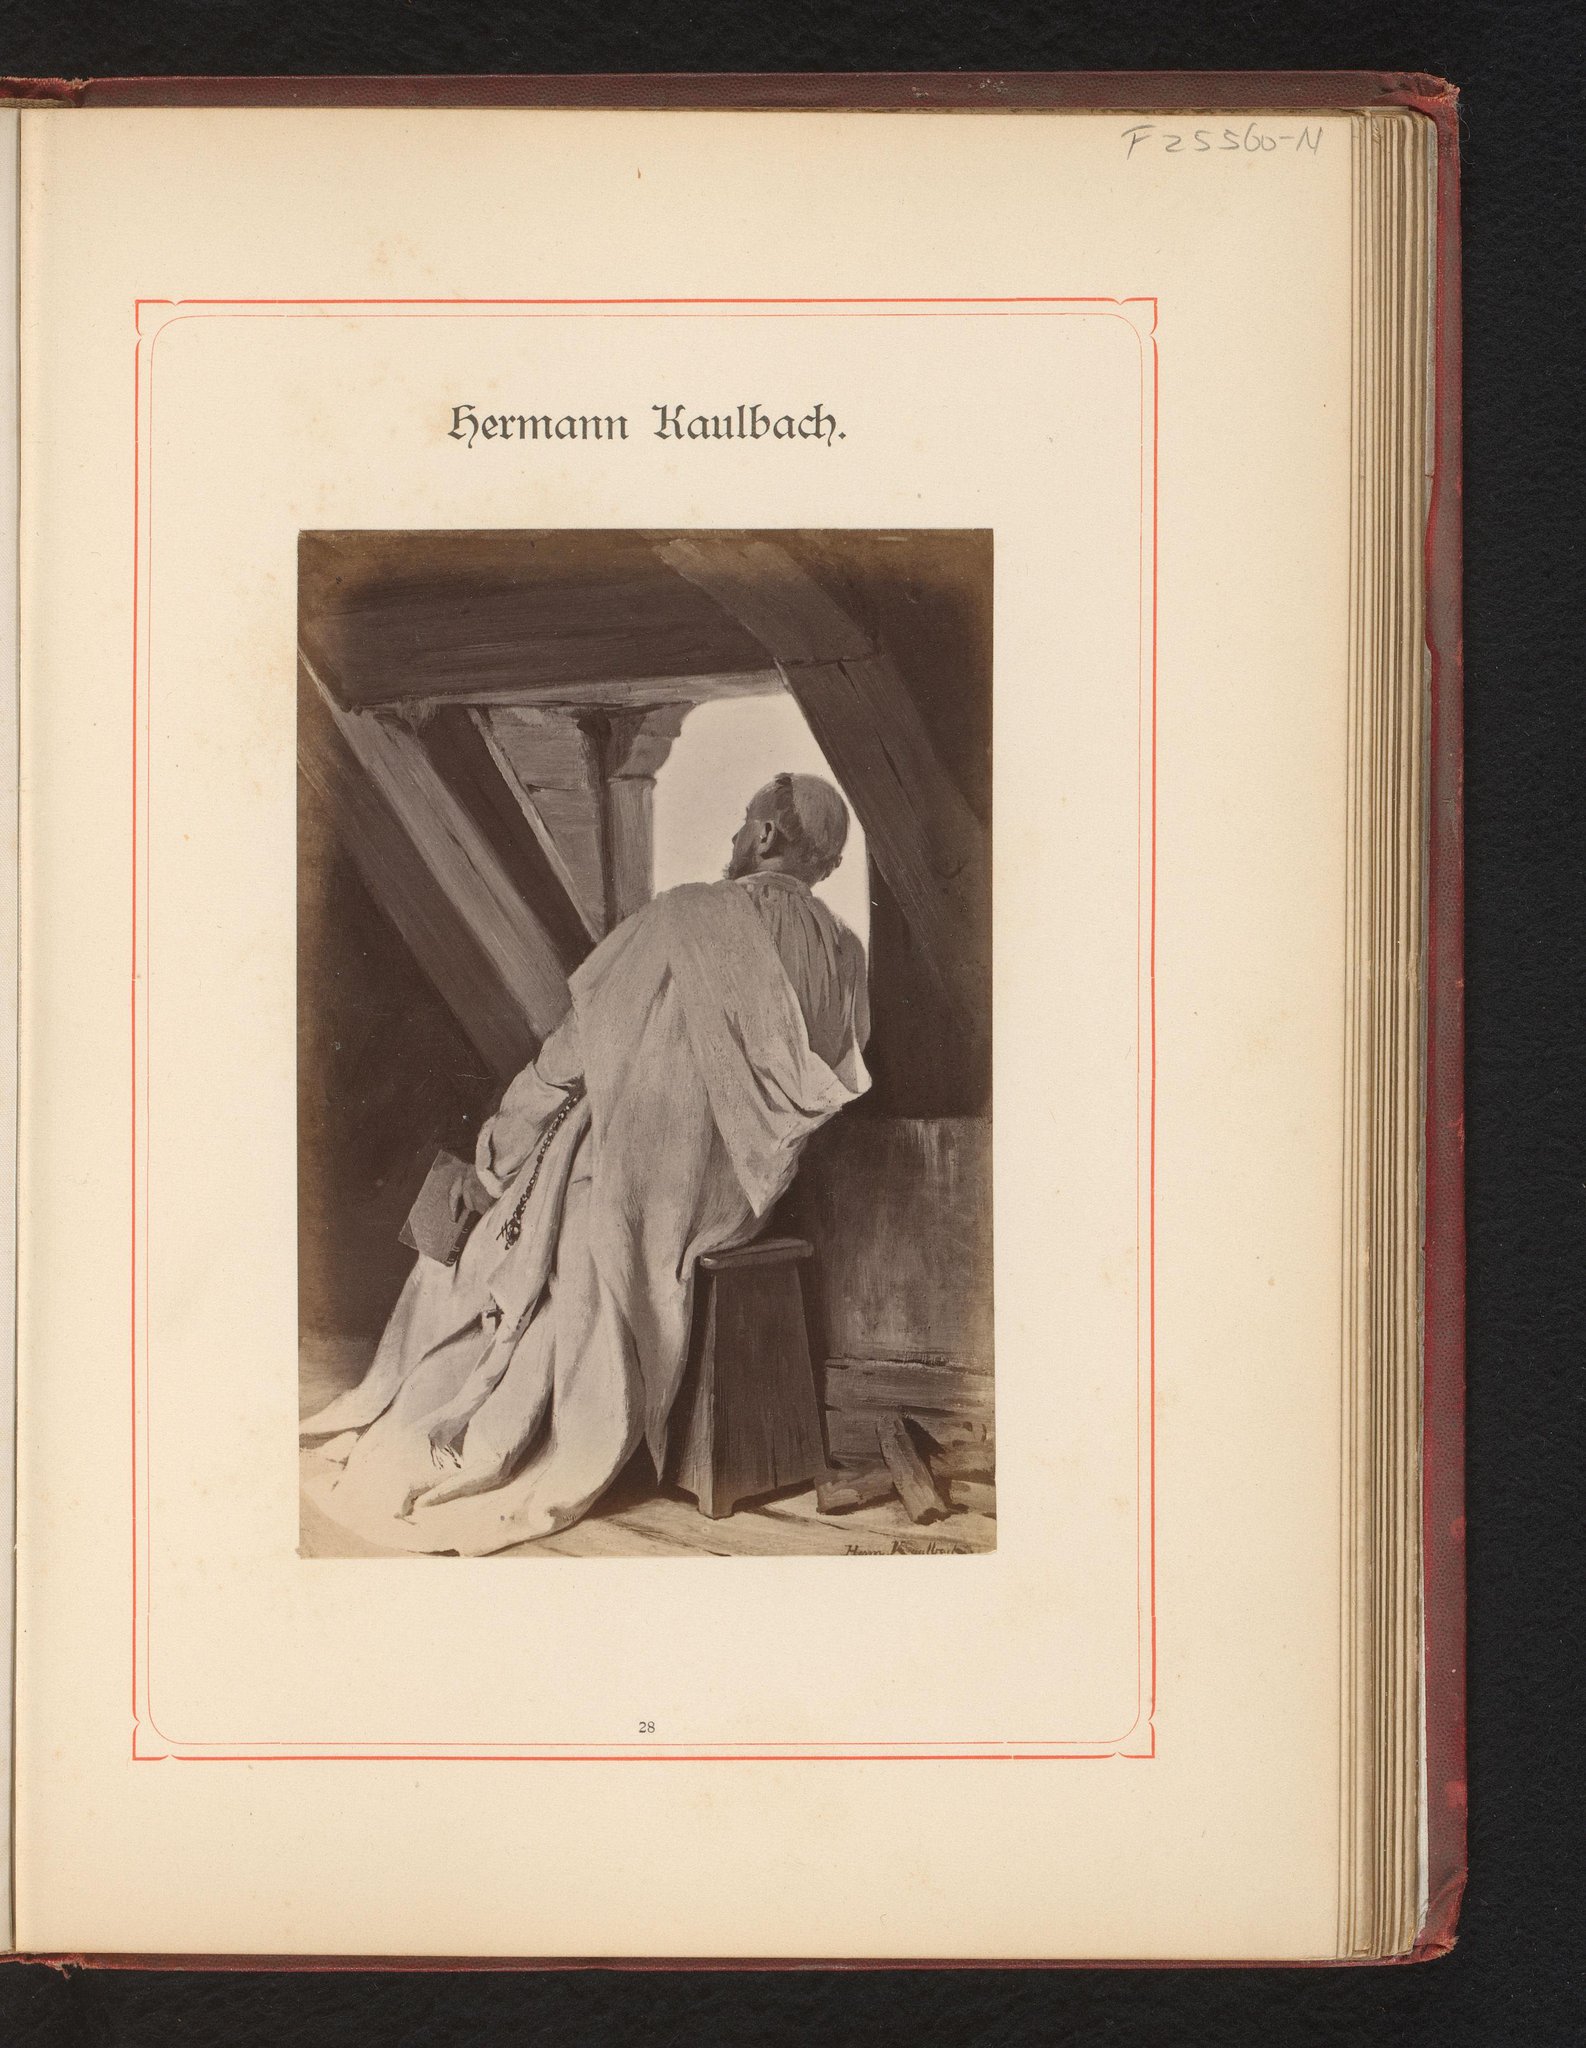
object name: photograph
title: Fotoreproductie van een schilderij van een monnik kijkend uit een zolderraam door Hermann Kaulbach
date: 1870-1890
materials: paper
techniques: albumen print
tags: attic, loft, monk(s), friar(s), picture, painting